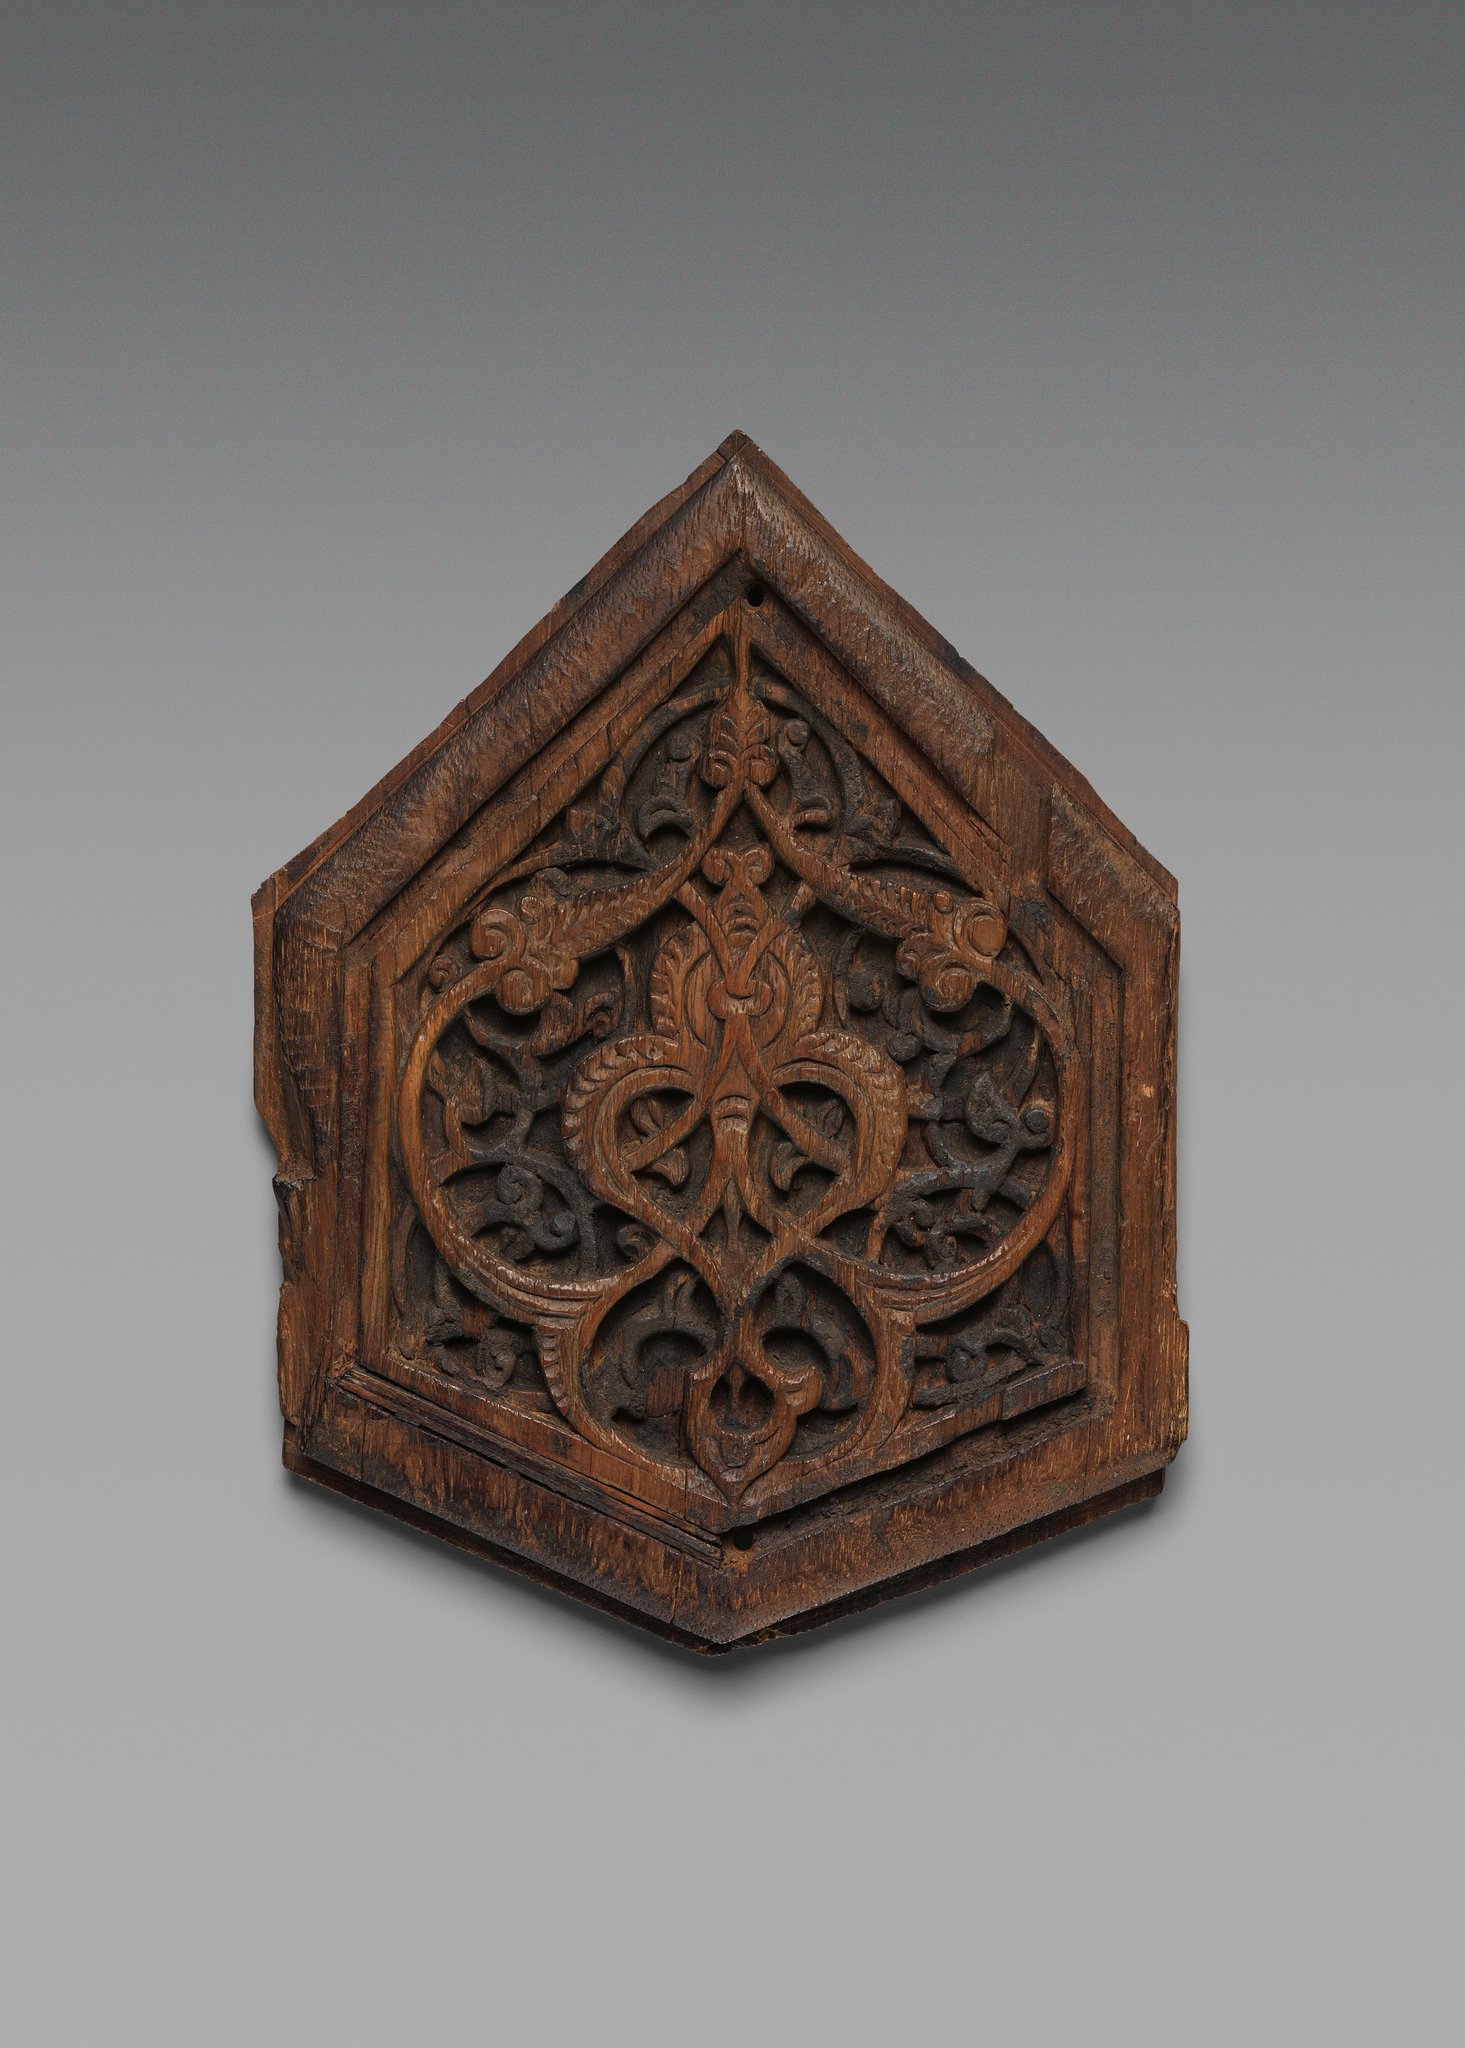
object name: panel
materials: wood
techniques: carving, inlay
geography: egypt